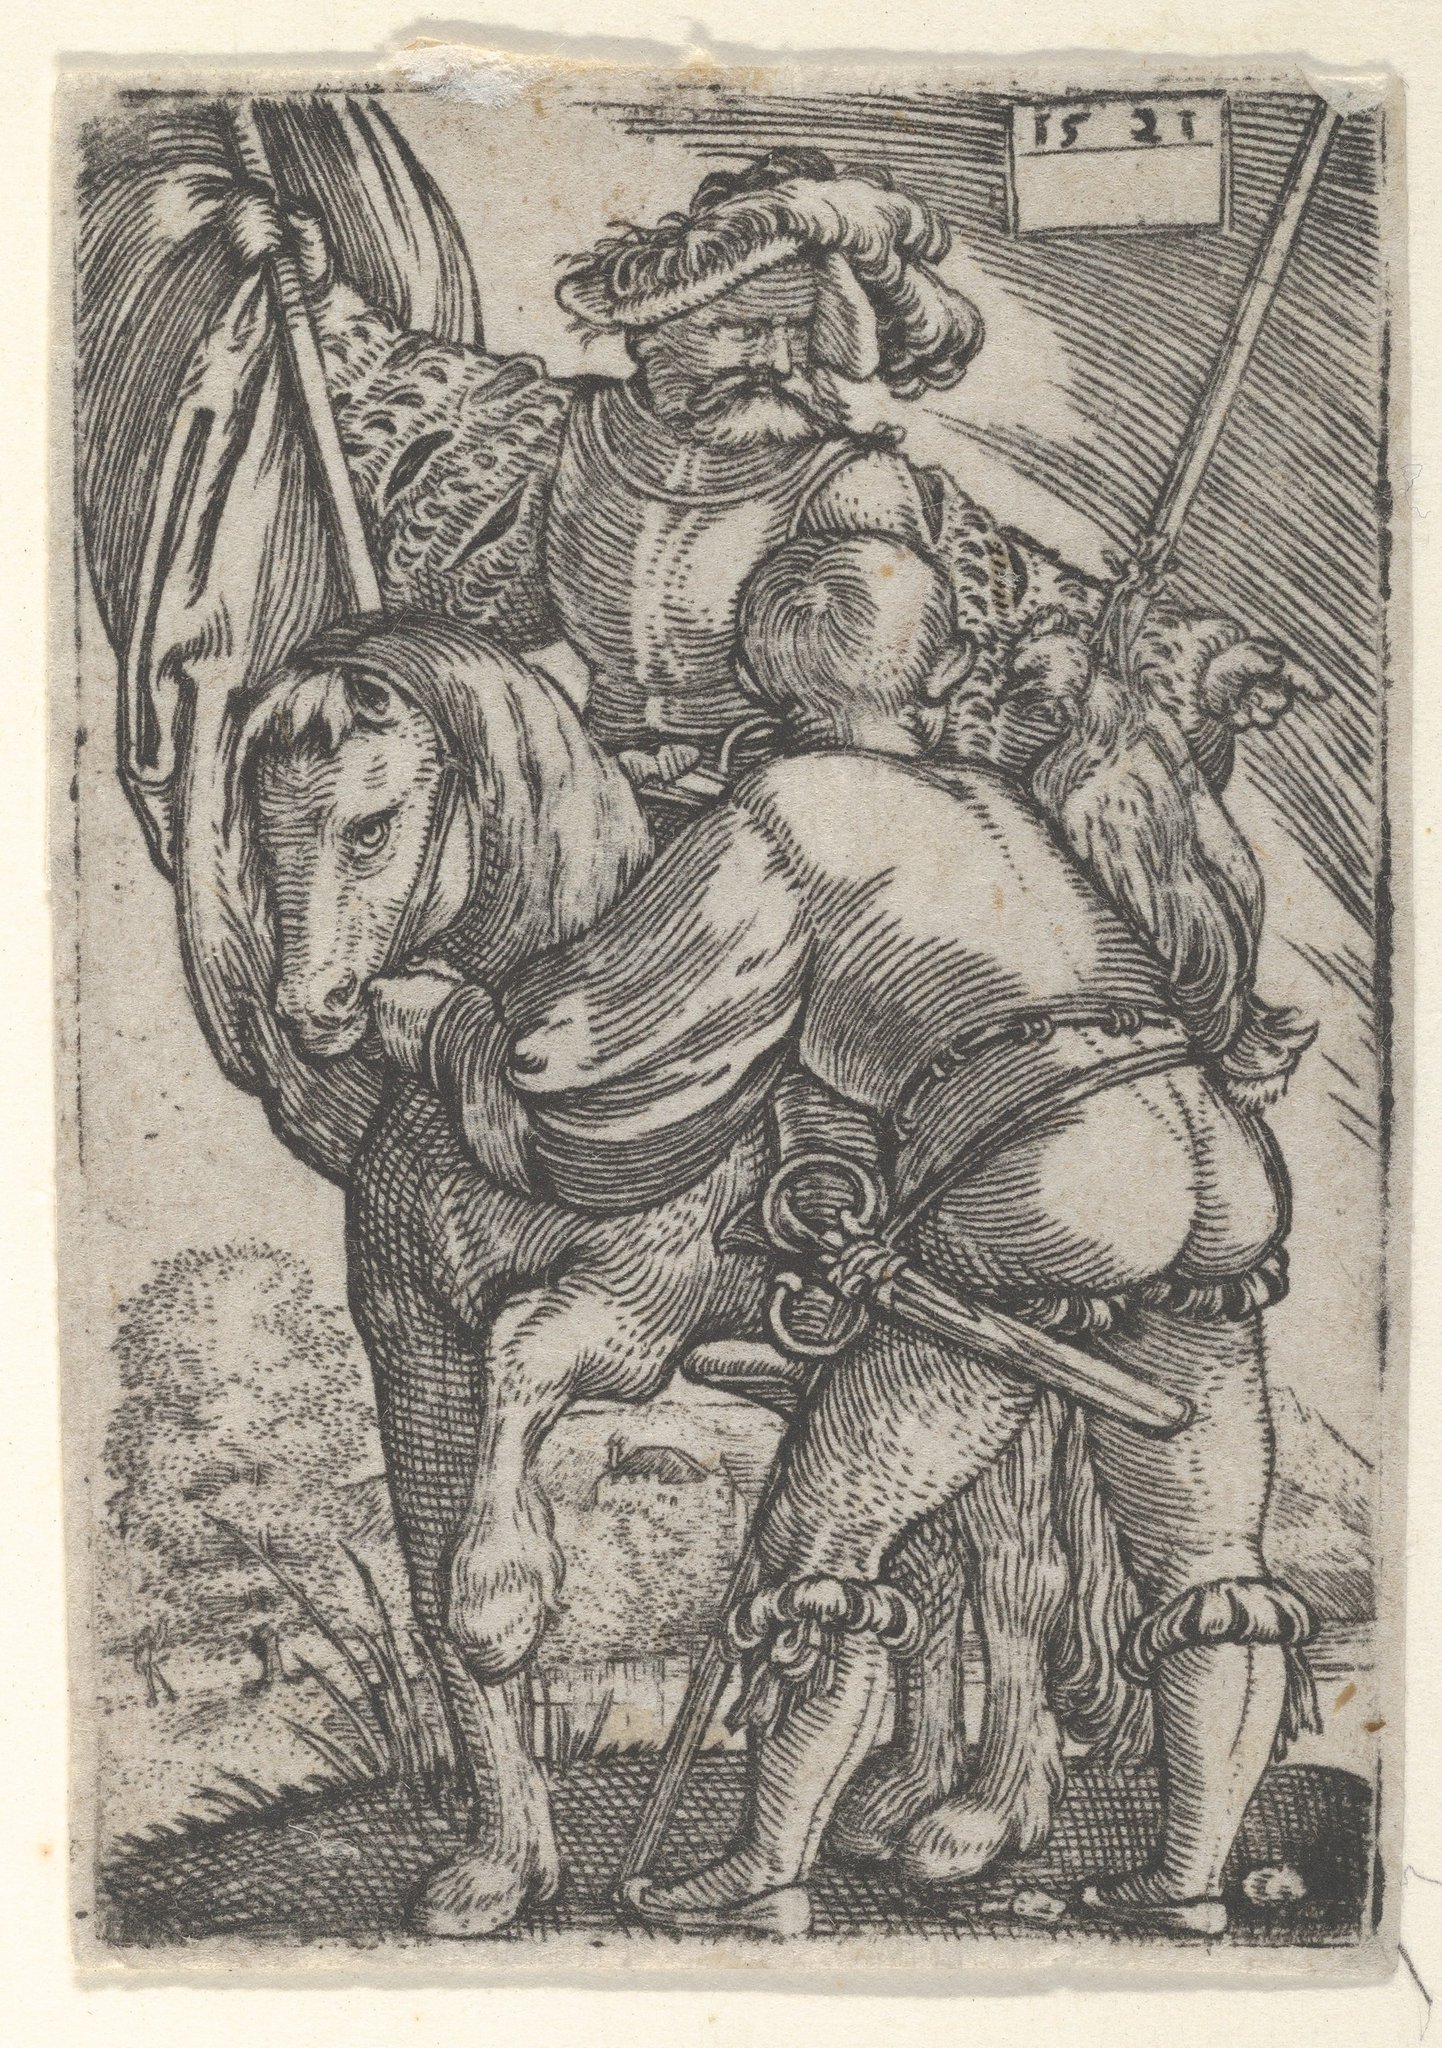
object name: print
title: Riding Standard Bearer and a Foot Soldier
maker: barthel beham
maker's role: artist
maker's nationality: german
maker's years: 1502-1540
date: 1501-1533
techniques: engraving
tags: soldiers,men,horses